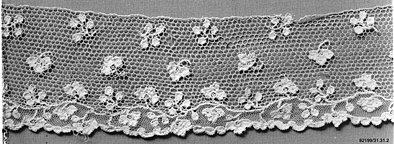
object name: edging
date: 1701-1800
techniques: lace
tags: flowers